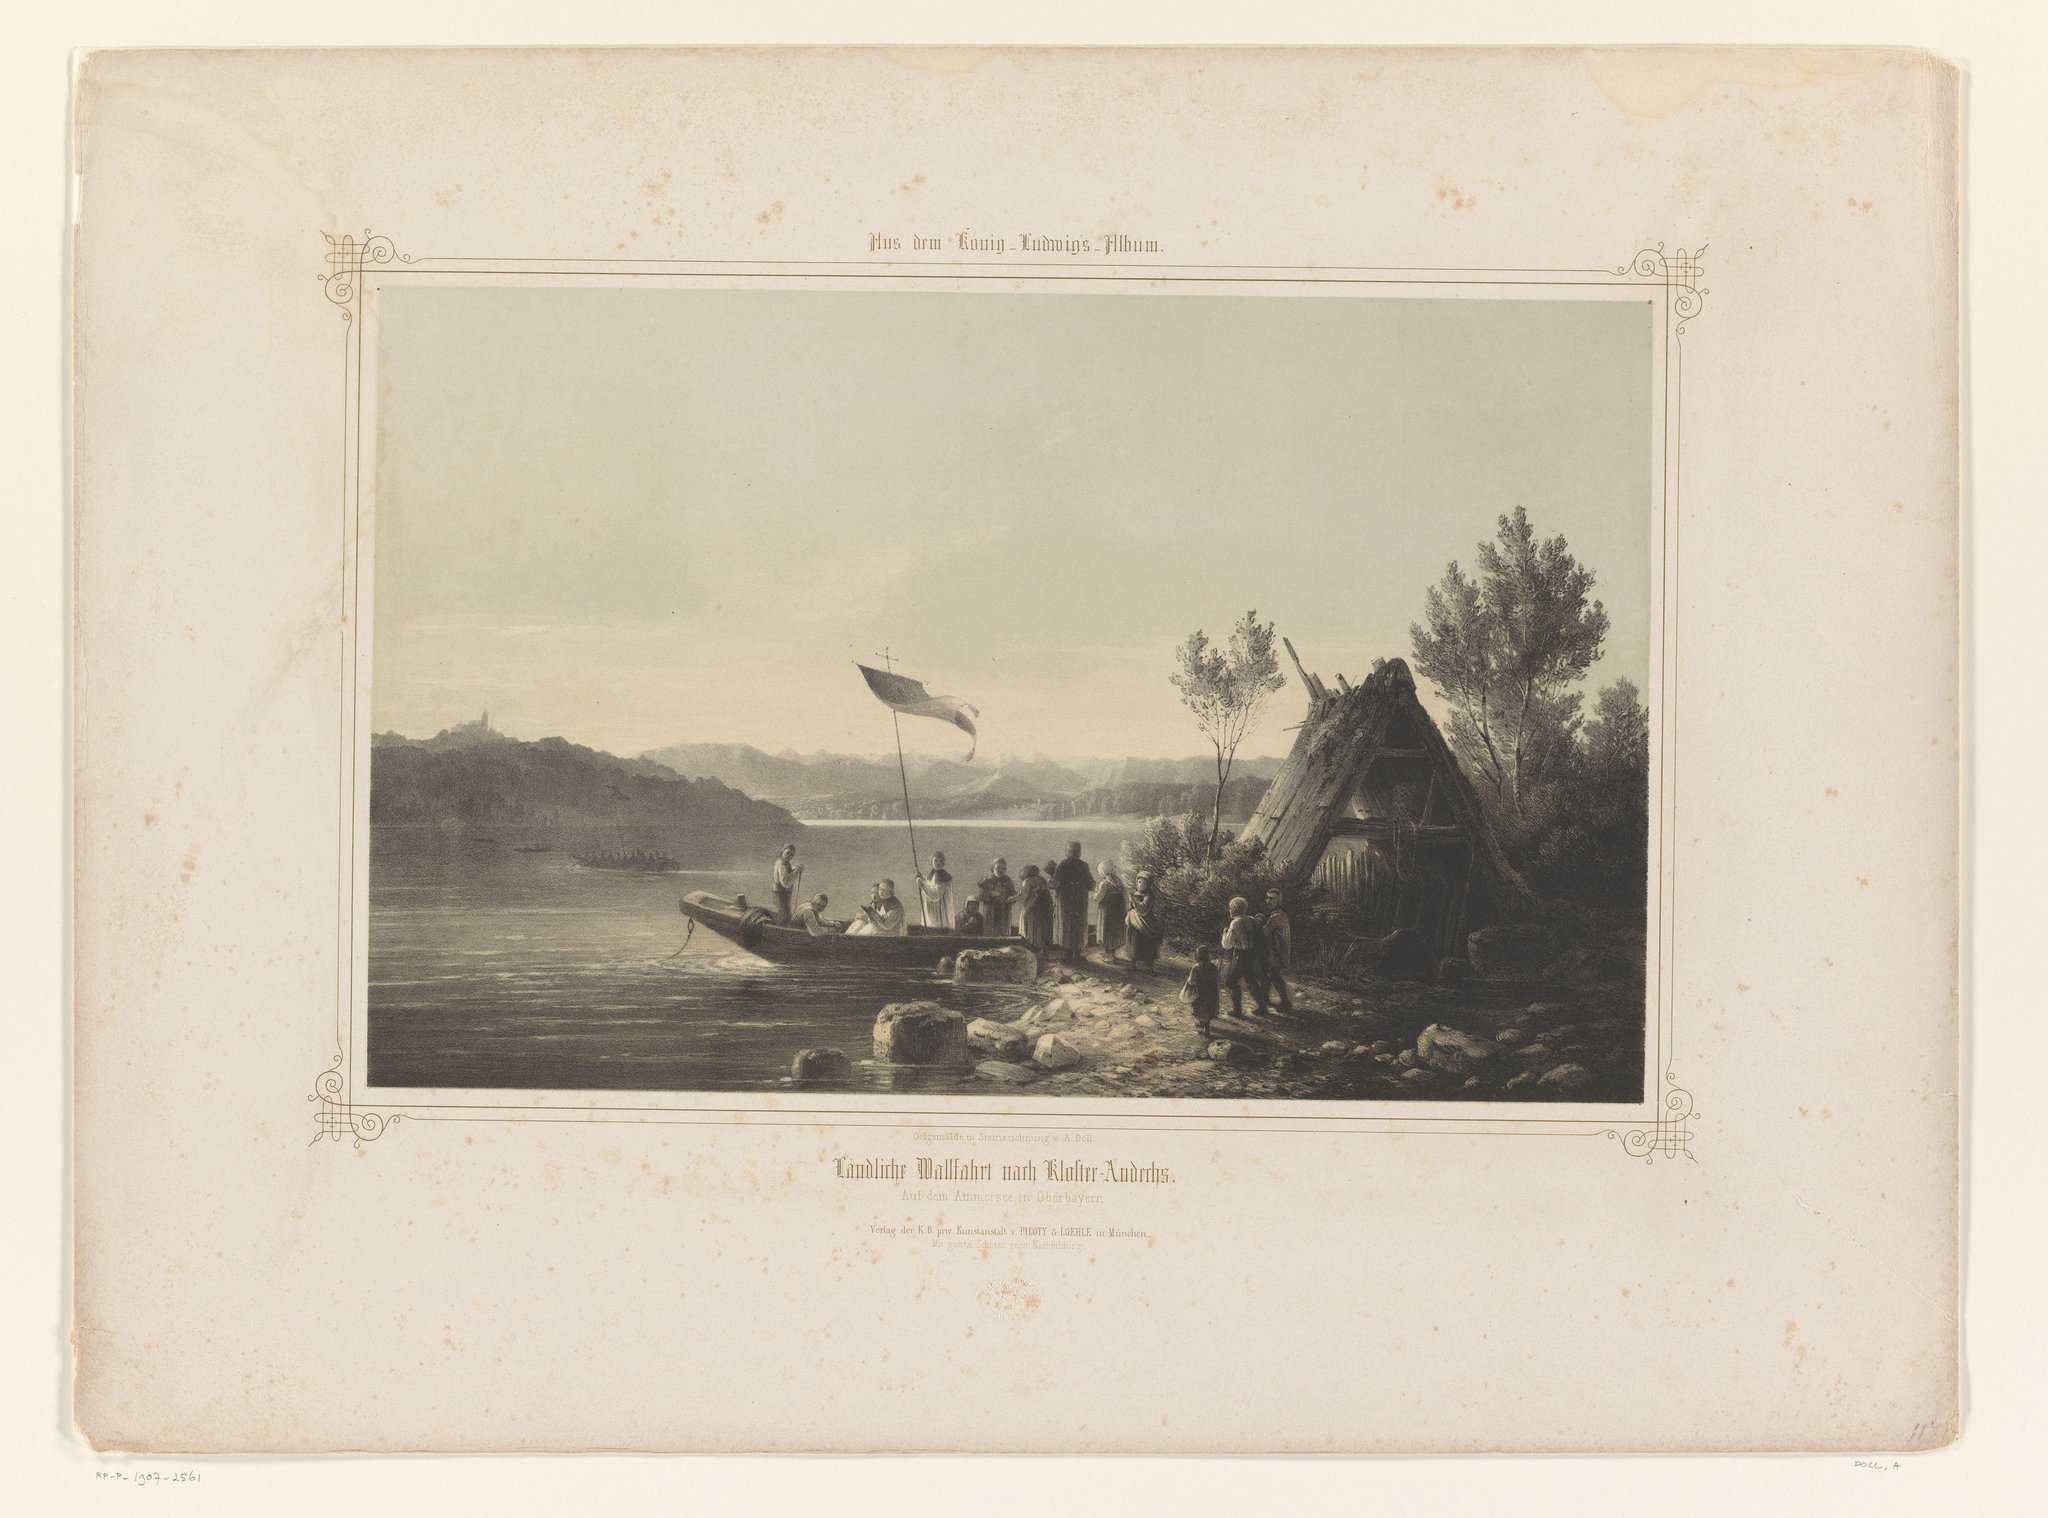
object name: print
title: Mensen steken met roeiboten een rivier over naar de abdij van Andechs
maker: anton doll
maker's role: painter, print maker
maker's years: 1826-1887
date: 1850-1859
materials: paper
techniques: tone lithography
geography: munich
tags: crossing a river, rowing-boat, canoe, etc., river (+ landscape with figures, staffage)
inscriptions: collector's mark: Lugt 2228, check stamp: ‘Piloty&Loehle, München’, : ‘Mit gesetzl Schutze gegen Nachbildung’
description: Prent afkomstig uit de serie 'Album Seiner Majestät des Königs Ludwig I. von Bayern', verschenen in verschillende afleveringen. De prenten gaan terug op het album dat Lodewijk I van Beieren op 9 oktober 1850 kreeg overhandigd van verschillende kunstenaars.